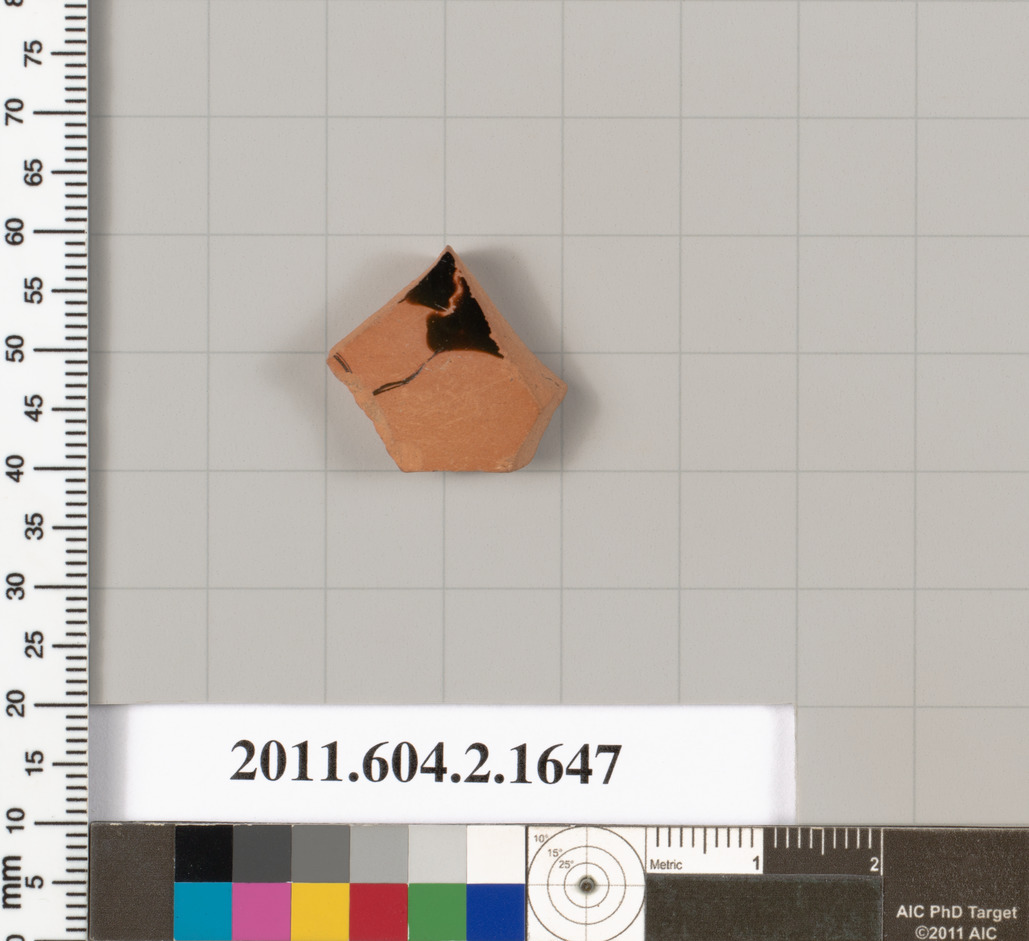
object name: skyphos fragment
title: Terracotta fragment of a skyphos (deep drinking cup)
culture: greek, attic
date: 490-470 BCE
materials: terracotta